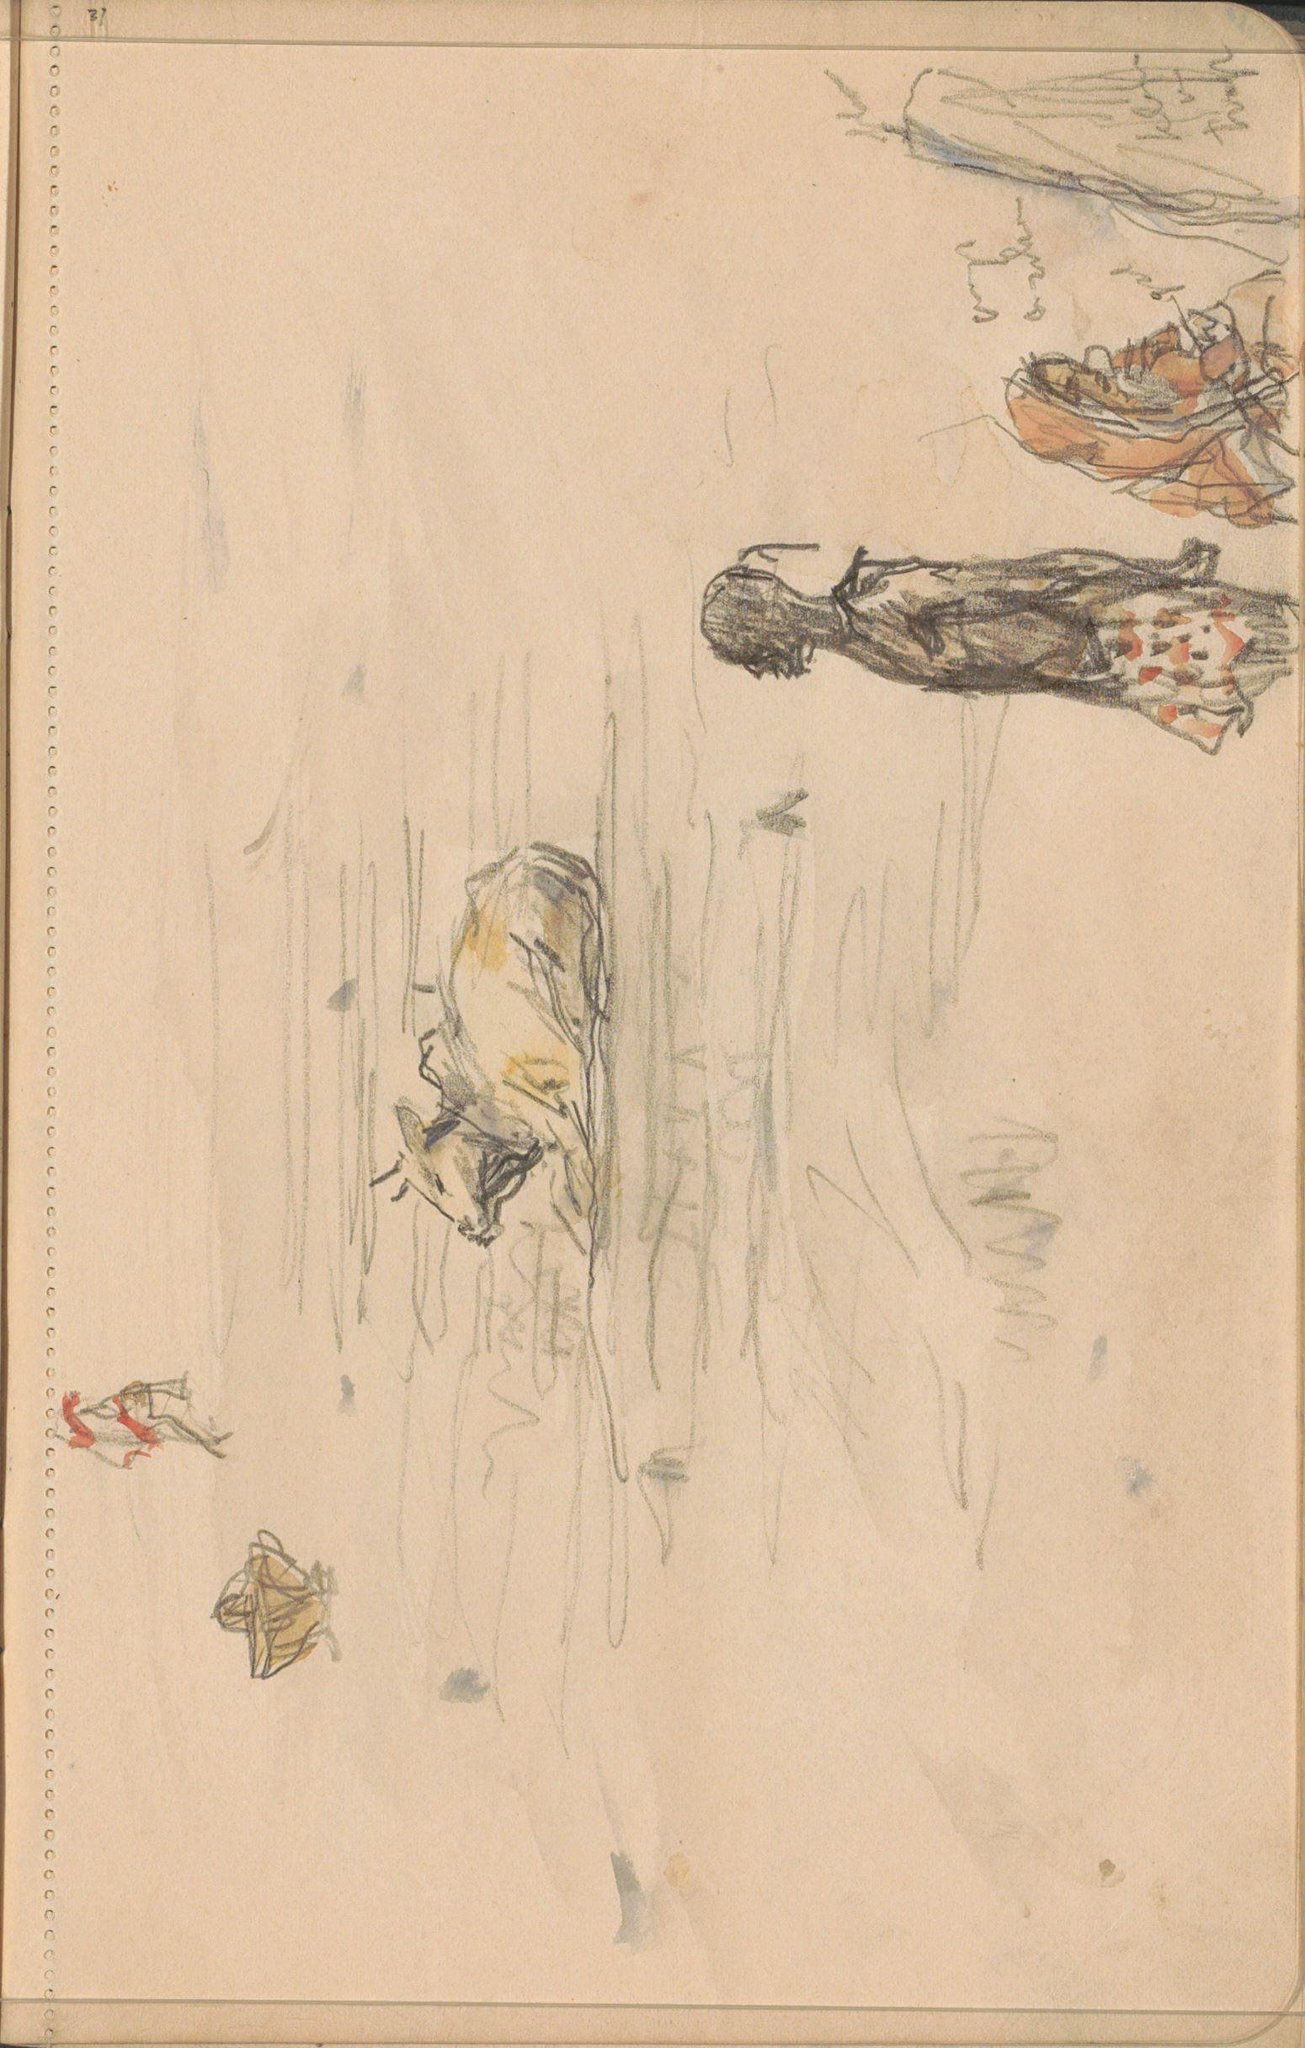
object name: sketchbook leaf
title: Indiase man en vrouw en een liggende os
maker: marius bauer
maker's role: draughtsman, print maker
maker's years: 1867-1932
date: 1924-1925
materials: paper, pencil, watercolor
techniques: brush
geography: india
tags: folk costume, regional costume, ox, asiatic races and peoples: indians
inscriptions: kleurnotitie, handgeschreven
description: De figuren dragen traditioneel Indiaas kostuum. Pagina 37 uit een schetsboek met 87 bladen.